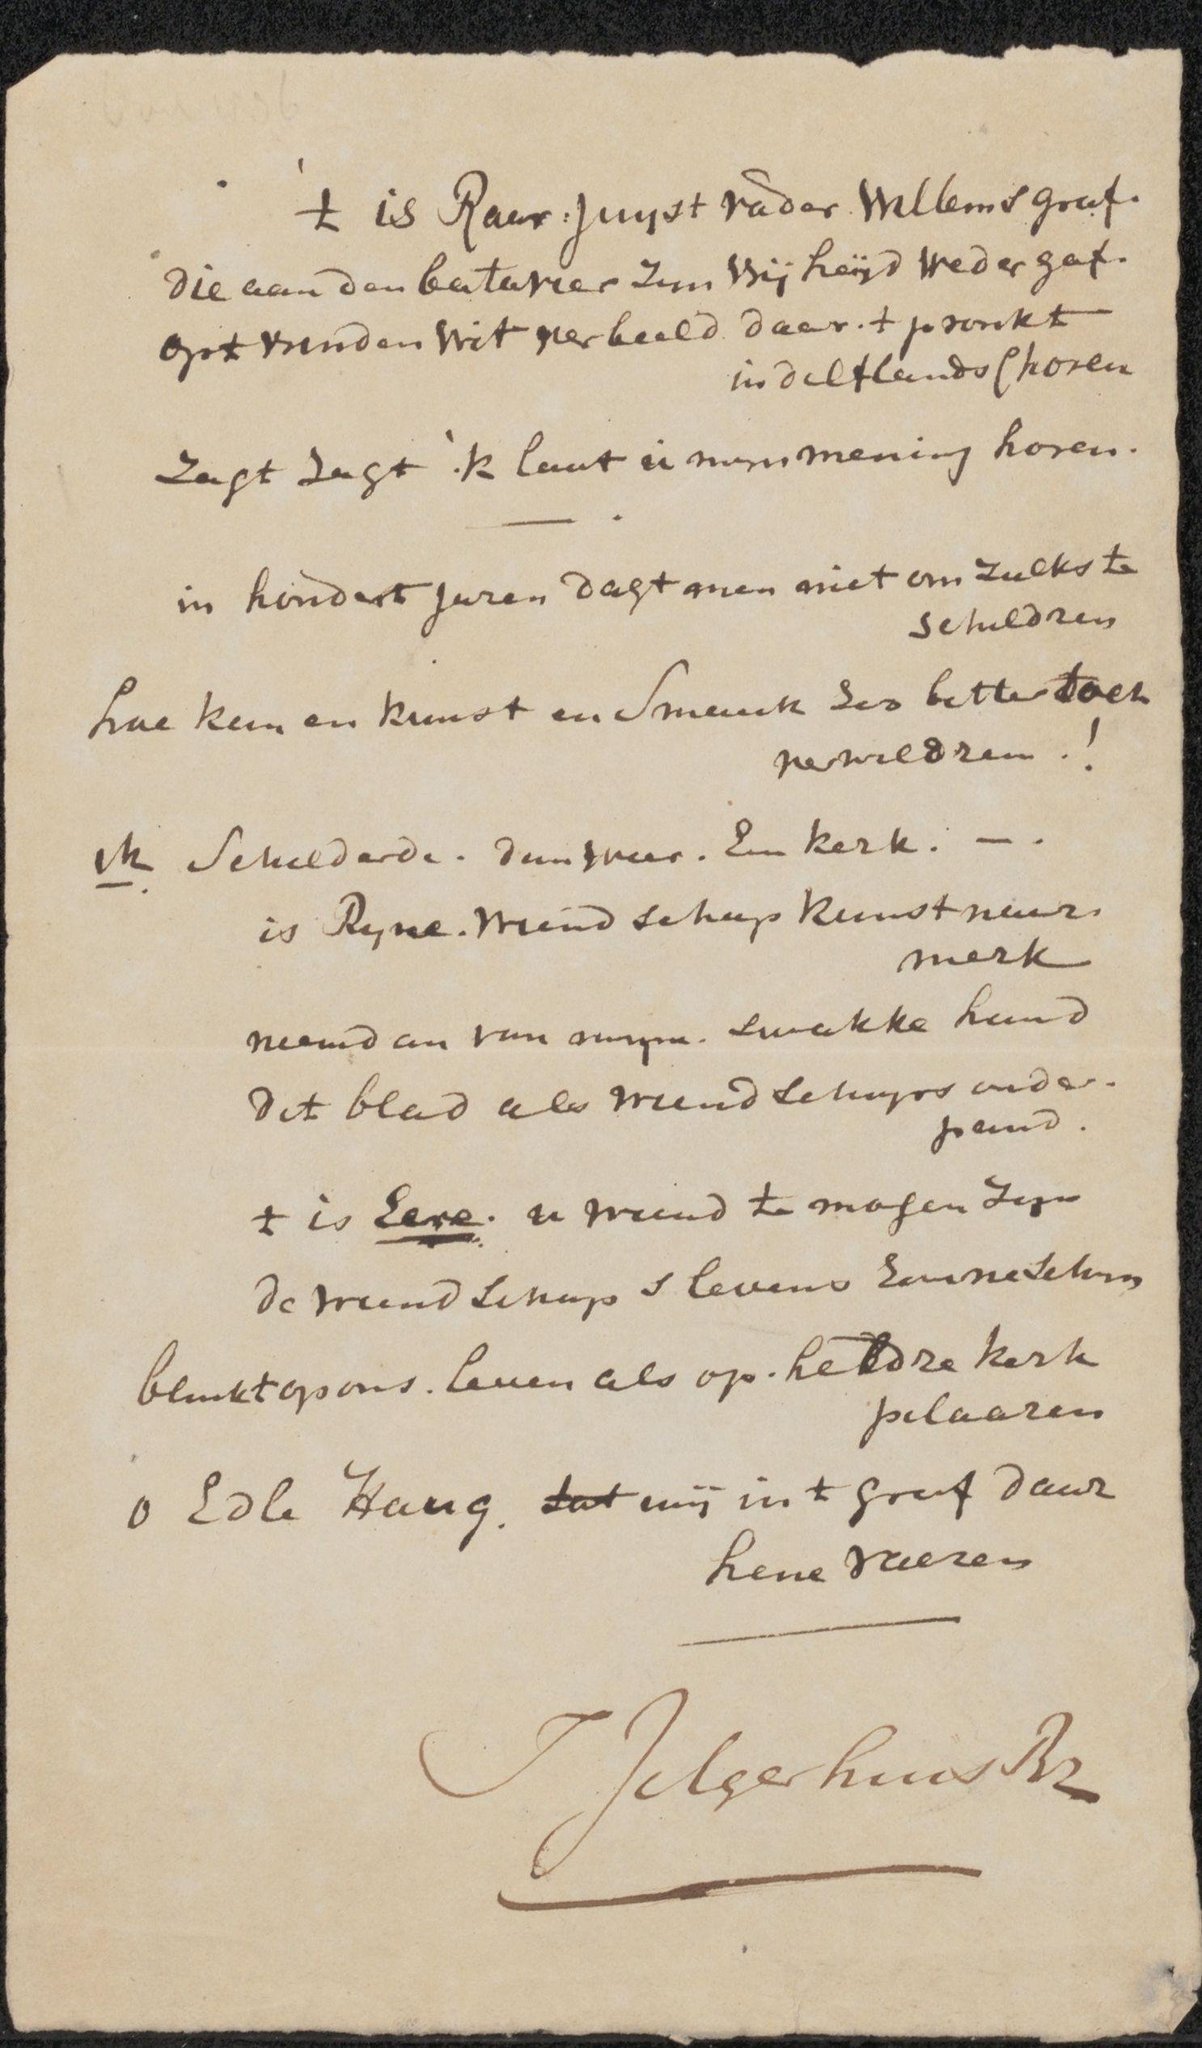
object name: poem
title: Gedicht aan L.F.C. Haug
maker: johannes jelgerhuis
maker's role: draughtsman, painter, print maker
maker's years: 1770-1836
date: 1783-1834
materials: ink, paper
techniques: pen, writing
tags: l.f.c. haug